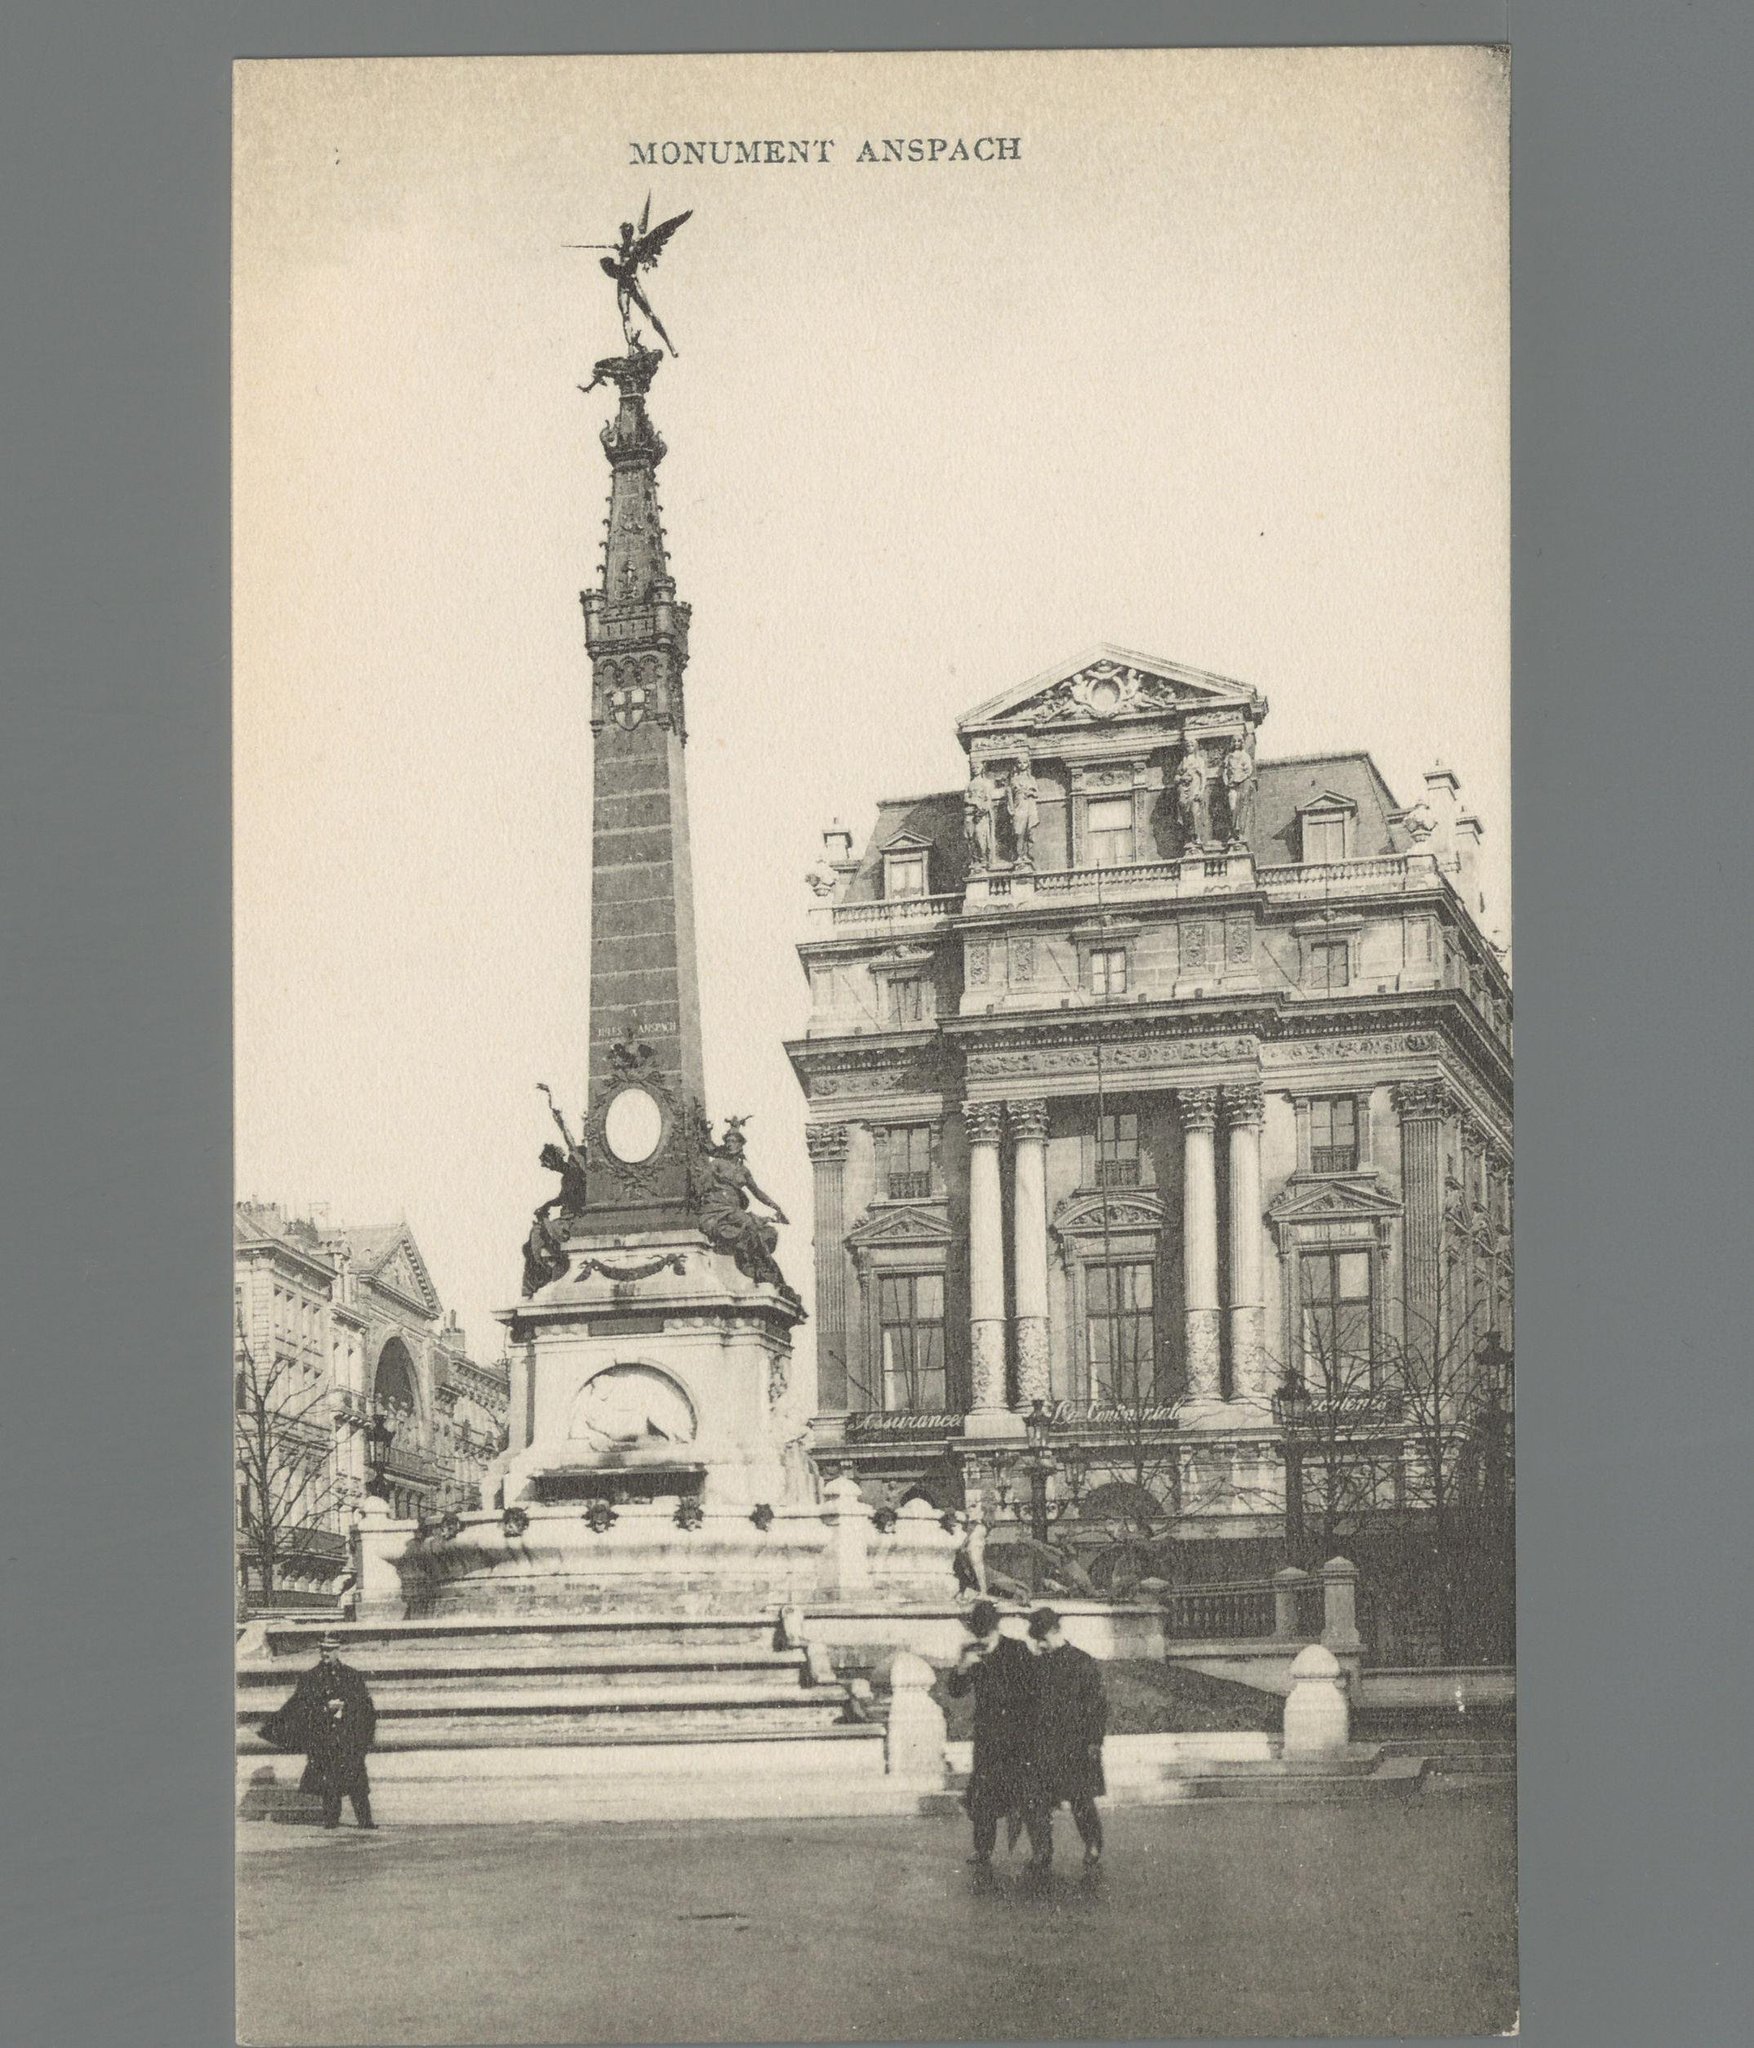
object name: ansichtkaart, prentbriefkaart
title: Monument Anspach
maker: Anonymous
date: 1906-1930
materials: cardboard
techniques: photograph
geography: brussels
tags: monument, statue, square, place, circus, etc. (+ city(-scape) with figures, staffage)